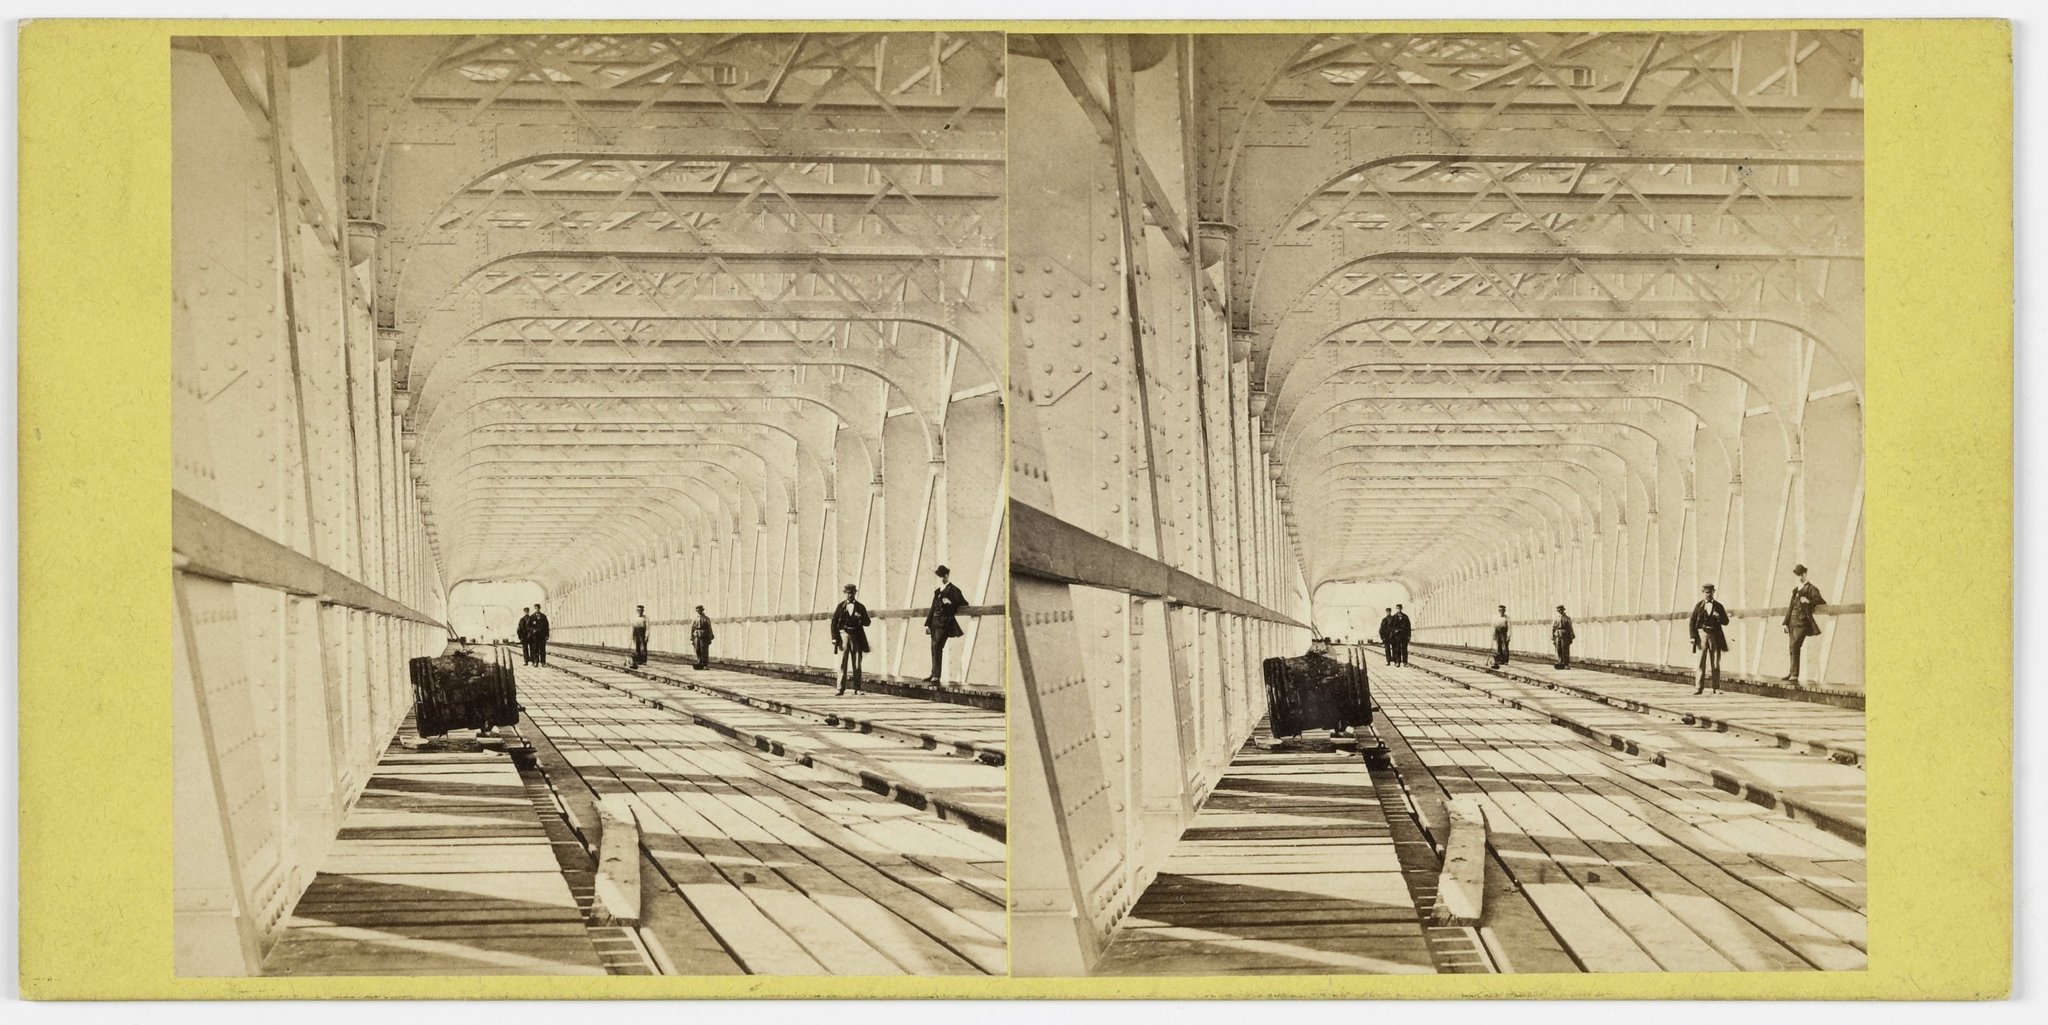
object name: stereograph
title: Spoorwegbrug te Culemborg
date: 1868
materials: cardboard, paper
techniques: albumen print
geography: culemborg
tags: railway, train, bridge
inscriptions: inscription: ‘(Nederland)’, number: ‘No. 7.’, inscription: ‘Uitgave van A.J. Blom, te Culemborg.’